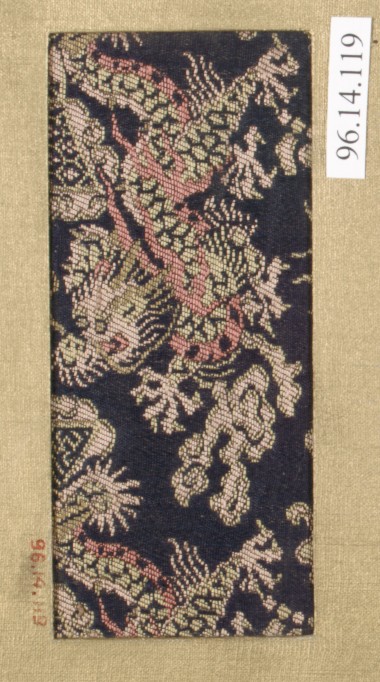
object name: piece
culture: japanese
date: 1701-1900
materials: silk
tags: dragons